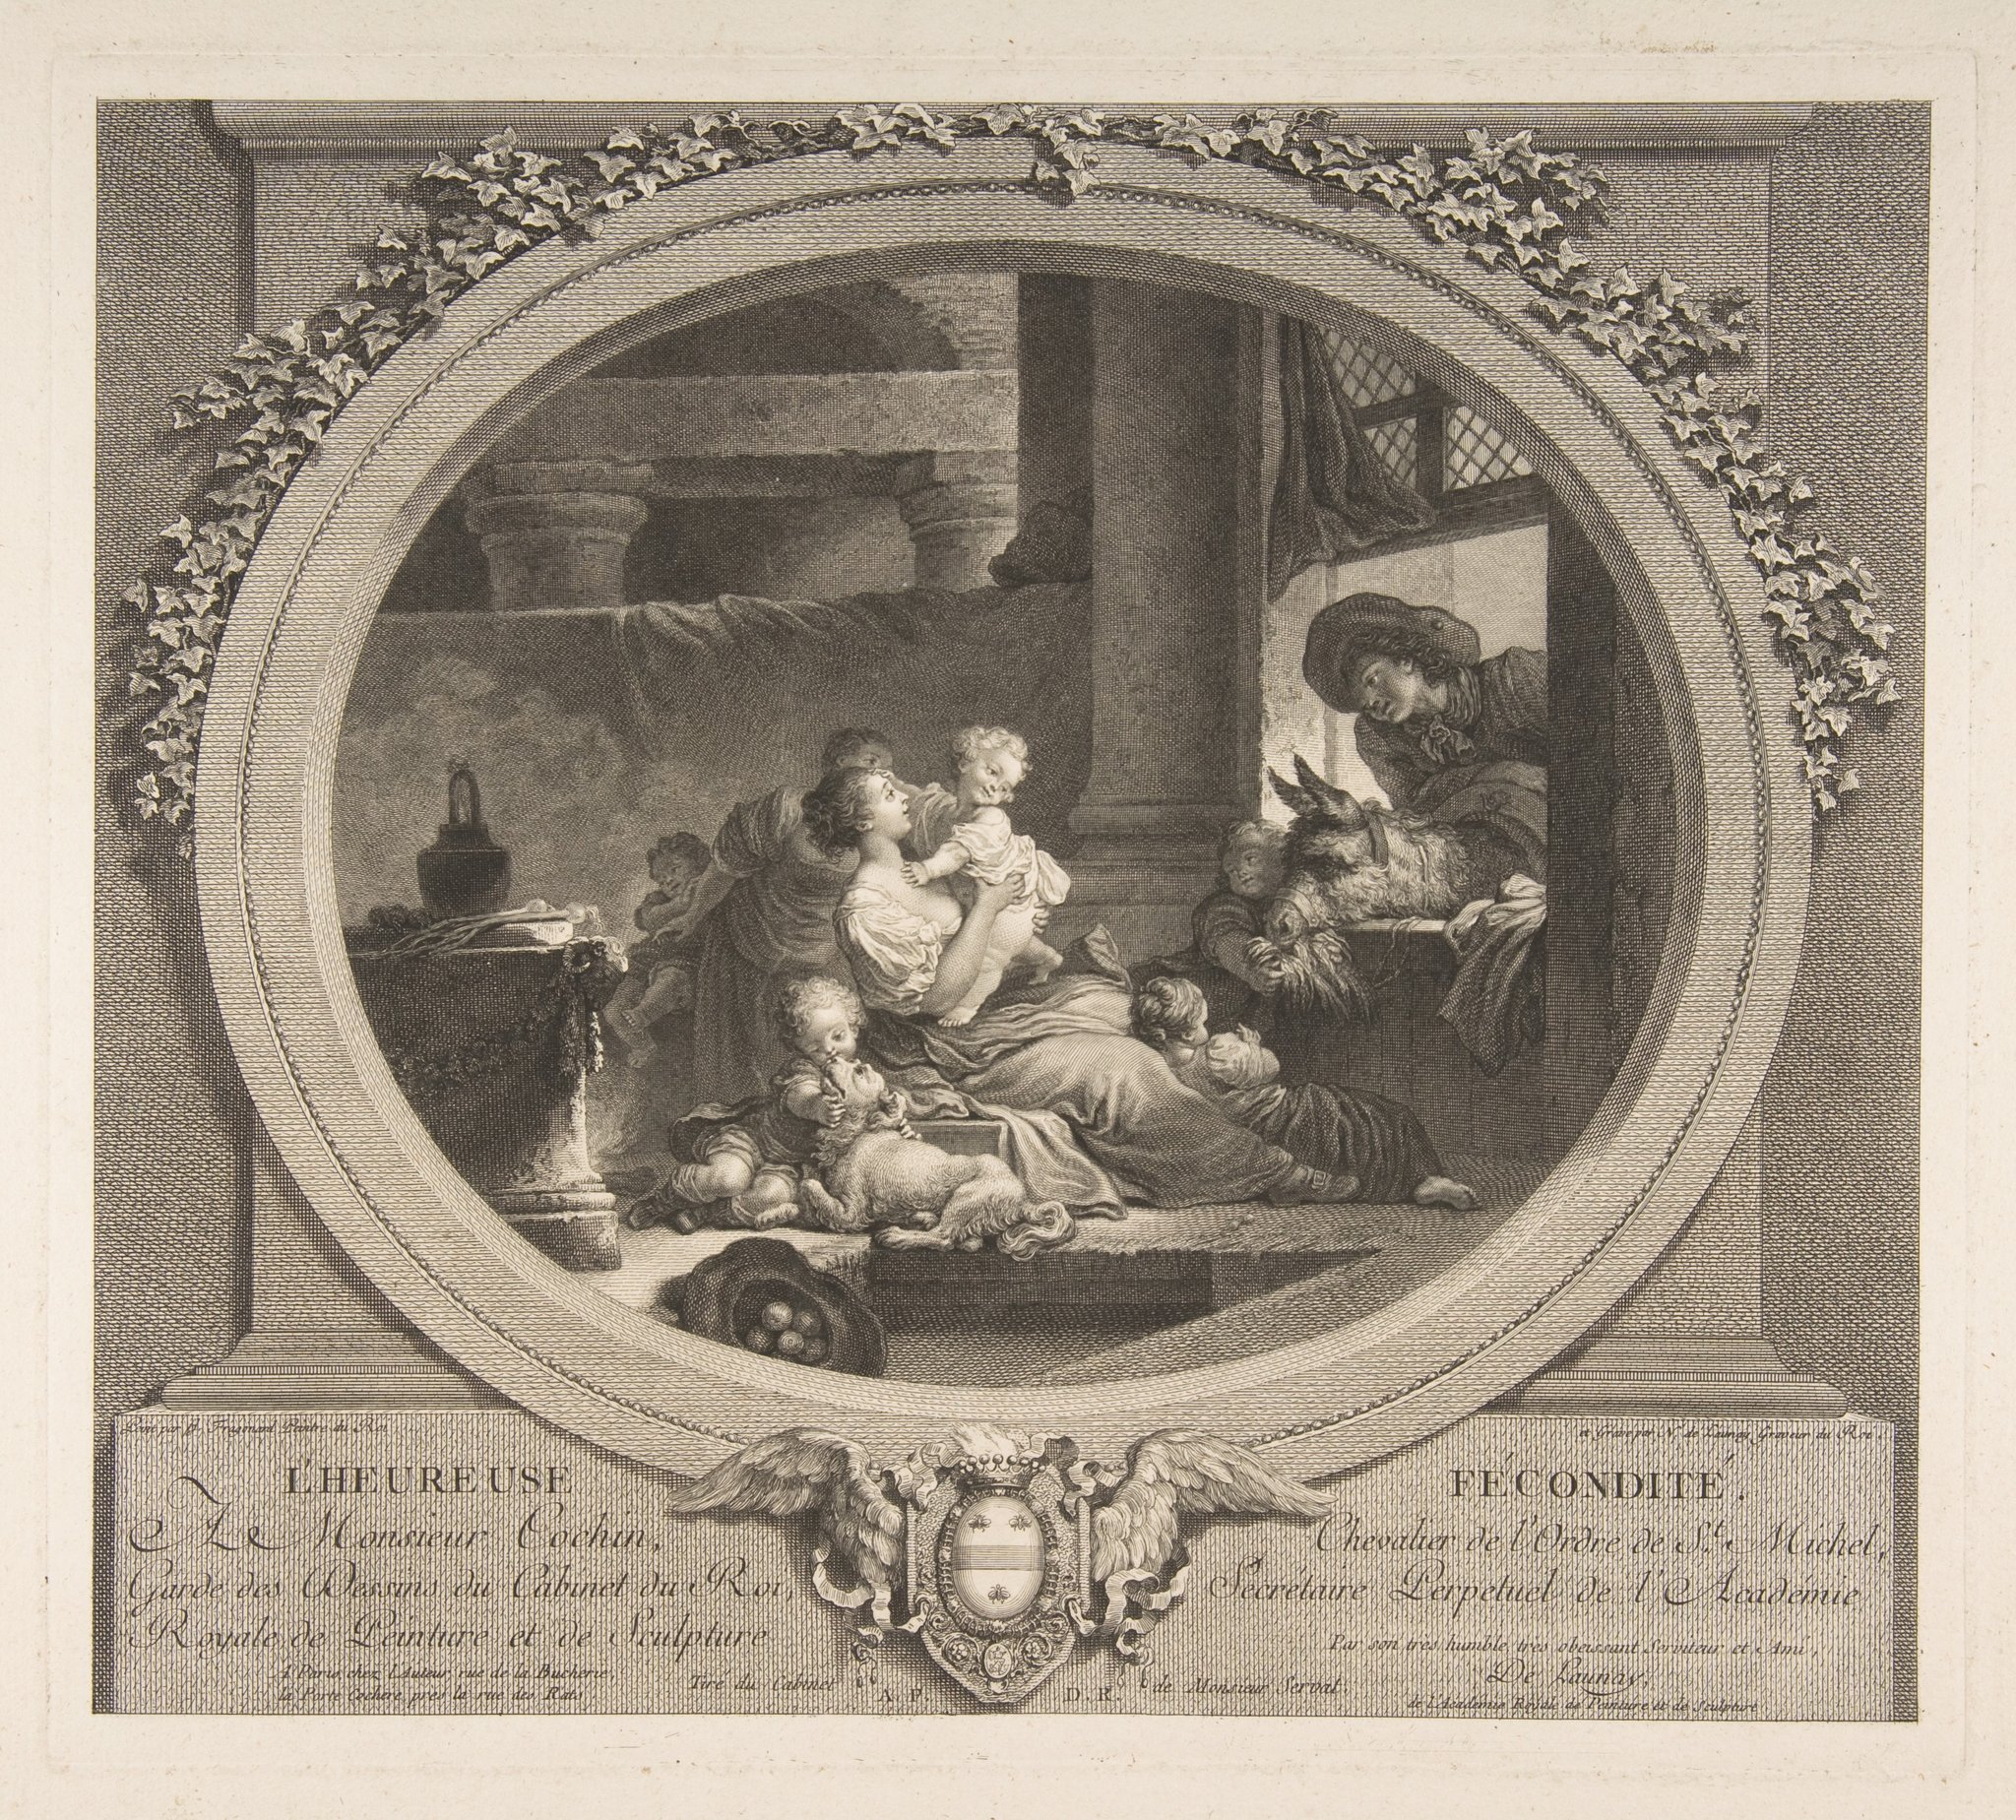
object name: print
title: L'Heureuse Fecondite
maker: jean honoré fragonard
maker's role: artist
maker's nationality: french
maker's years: 1732-1806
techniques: etching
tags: animals,infants,women,dogs,coat of arms